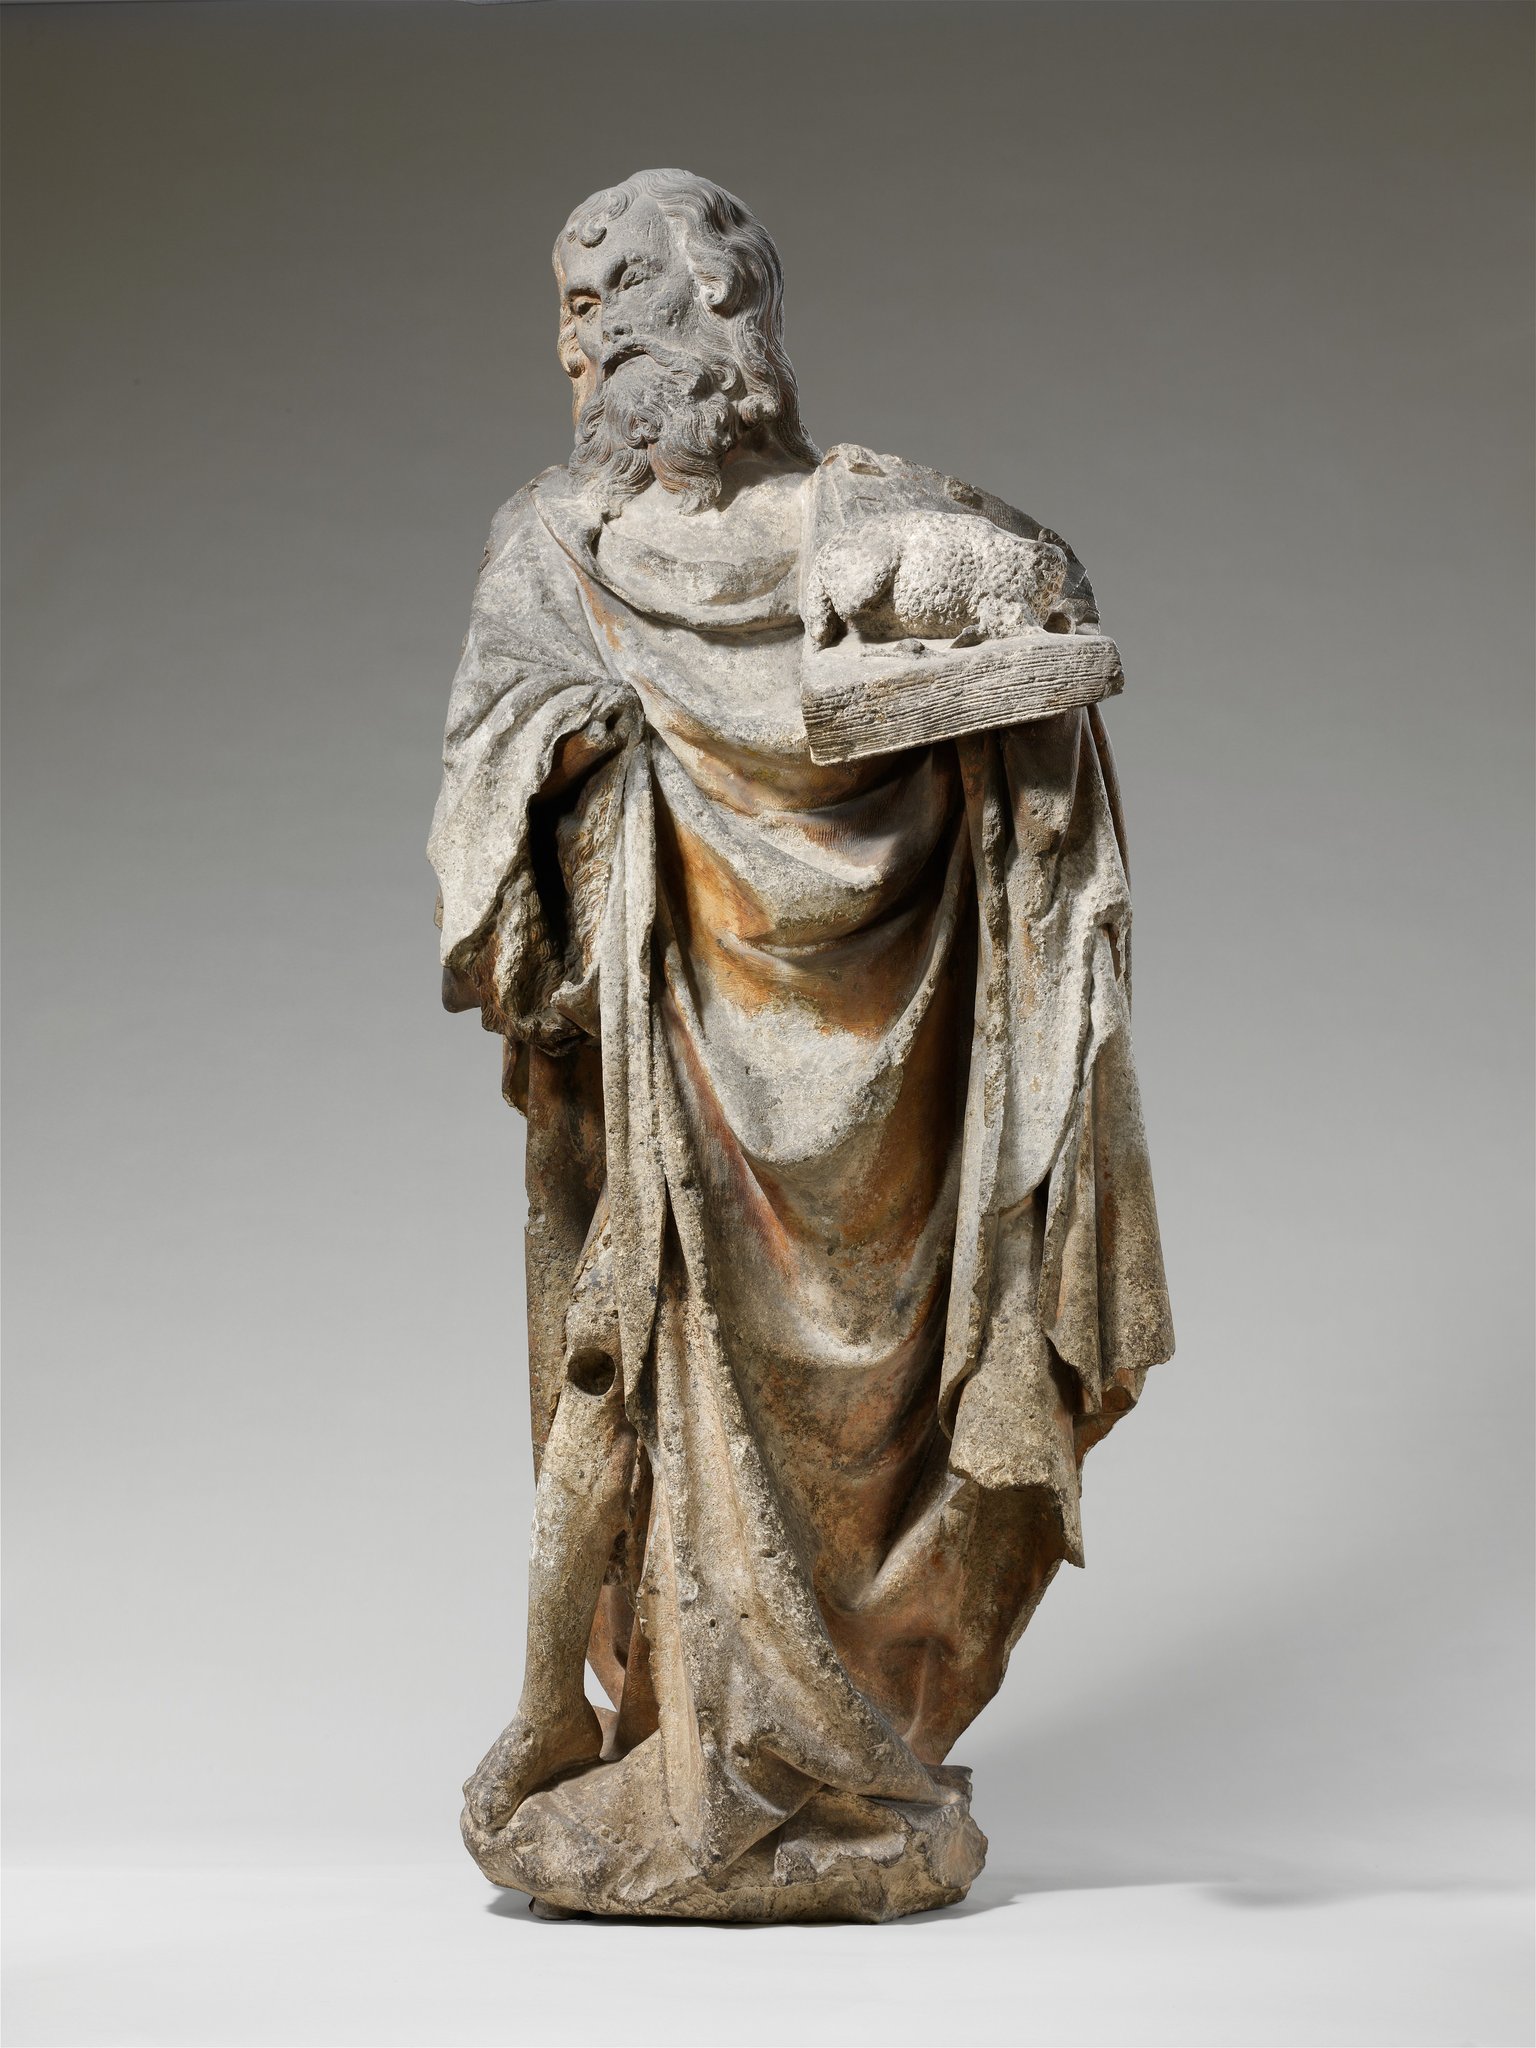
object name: statue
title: Saint John the Baptist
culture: french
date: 1450-1475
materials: limestone, paint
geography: france